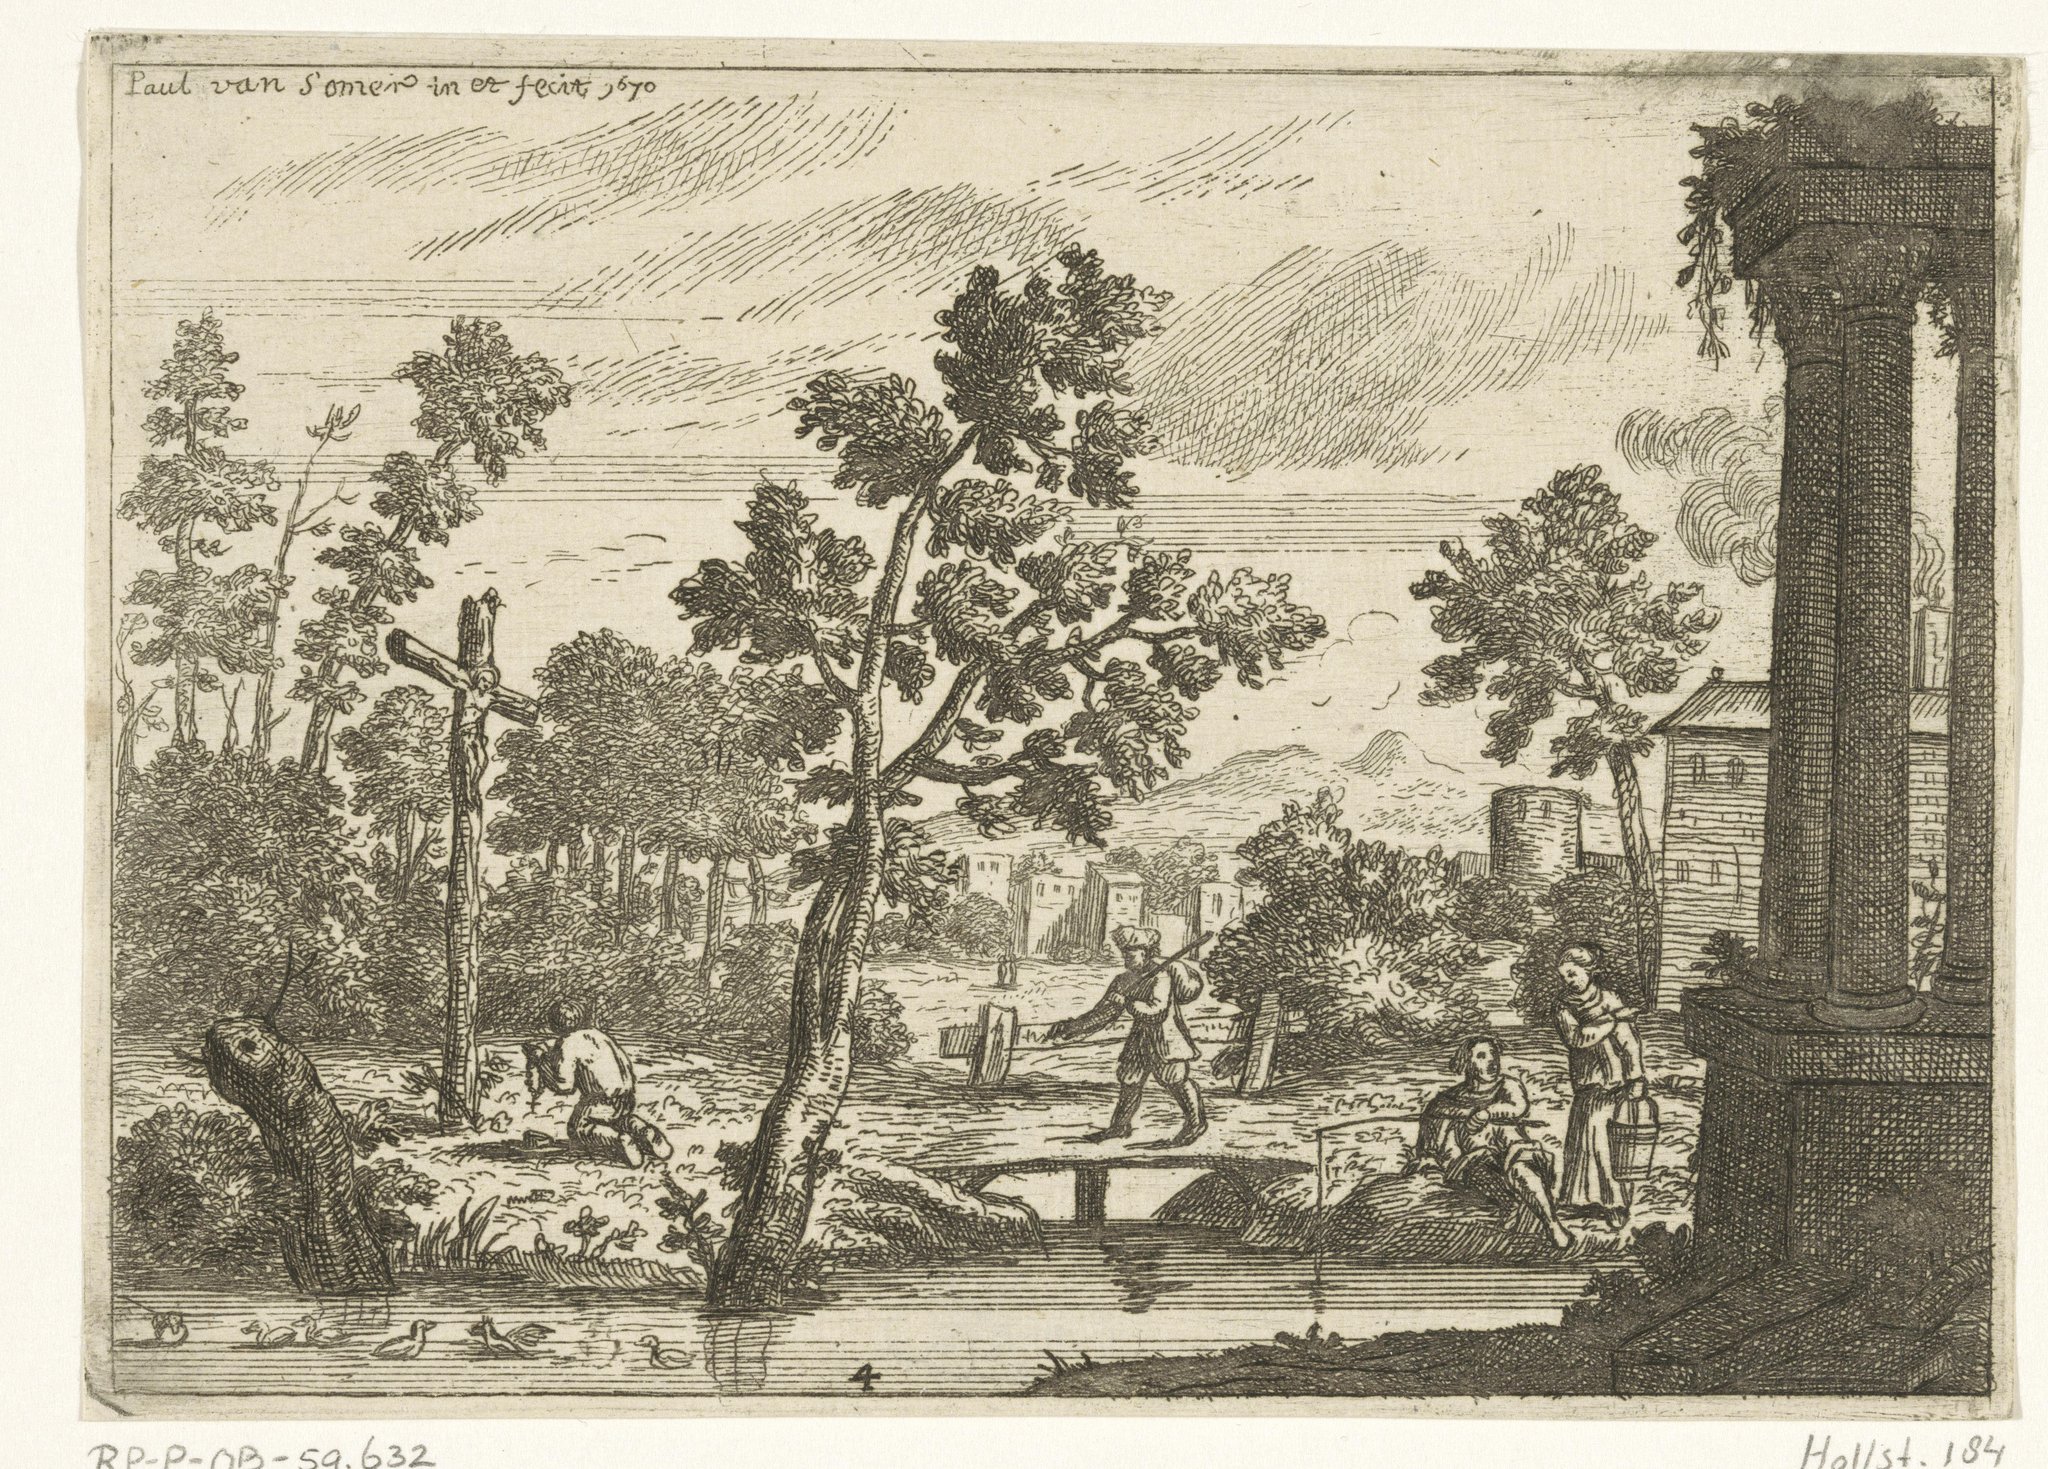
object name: print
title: Landschap met een man knielend voor een Kruis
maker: paul van somer (ii)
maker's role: draughtsman, print maker, publisher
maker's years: 1639-1704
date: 1670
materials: paper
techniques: engraving, etching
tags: venerating the cross, aids for prayer, e.g. rosary, quarrel, argument, landscape with ruins - ii - ideal landscapes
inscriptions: number: ‘No. 95’, collector's mark: Lugt 2228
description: Landschap met een man met rozenkrans, die geknield voor een kruis met Christusbeeld zit. Op de voorgrond een ruïne van een tempel met klassieke zuilen. Aan het water ruziet een vissende man met een vrouw die naast hem staat.